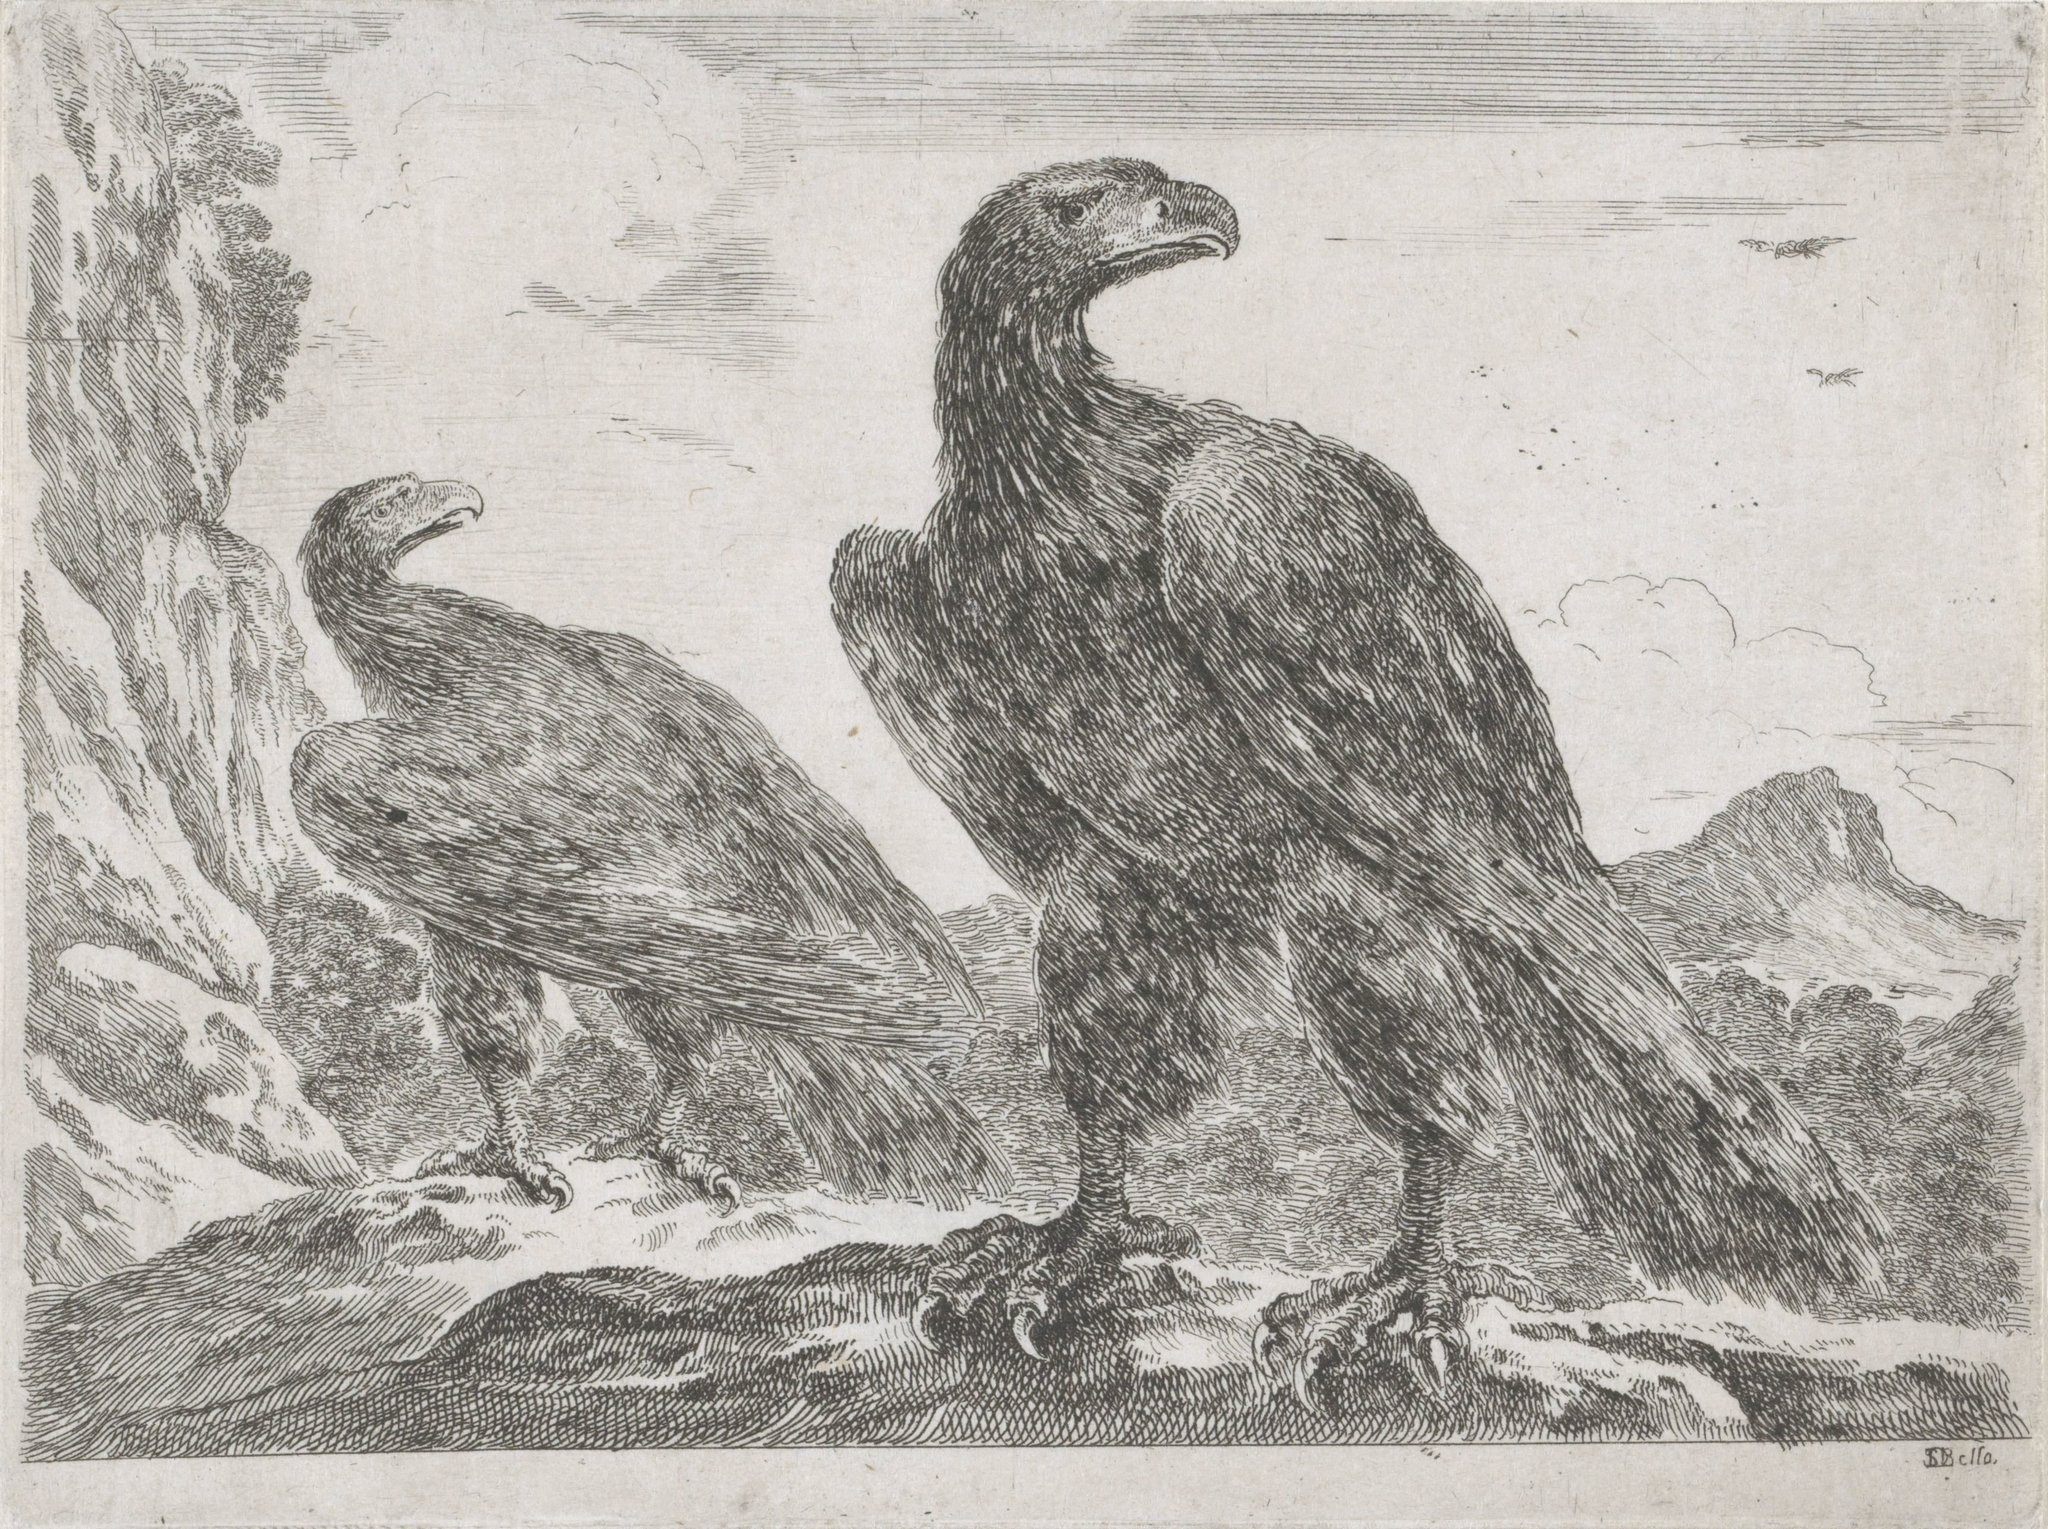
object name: print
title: Twee adelaars met koppen naar rechts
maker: stefano della bella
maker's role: draughtsman, print maker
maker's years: 1610-1664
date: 1620-1664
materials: paper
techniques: etching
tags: predatory birds: eagle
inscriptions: collector's mark: Lugt 2228, collector's mark: Lugt 2760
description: Twee adelaars op een rots met de koppen naar rechts. De linker adelaar op de rug gezien.